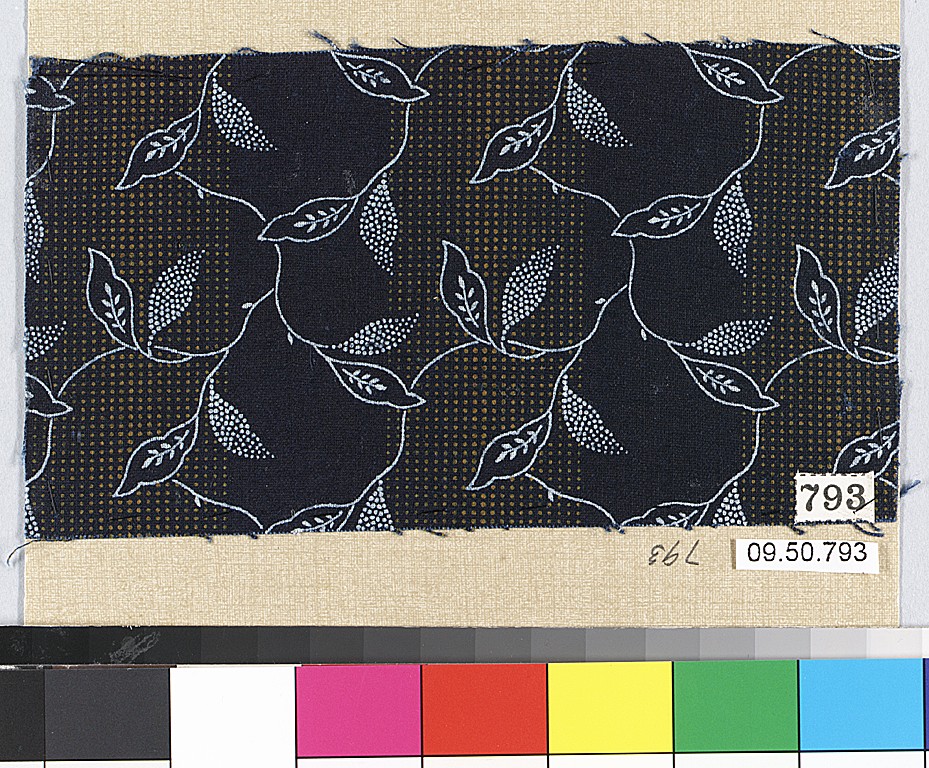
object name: piece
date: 1801-1900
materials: cotton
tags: leaves